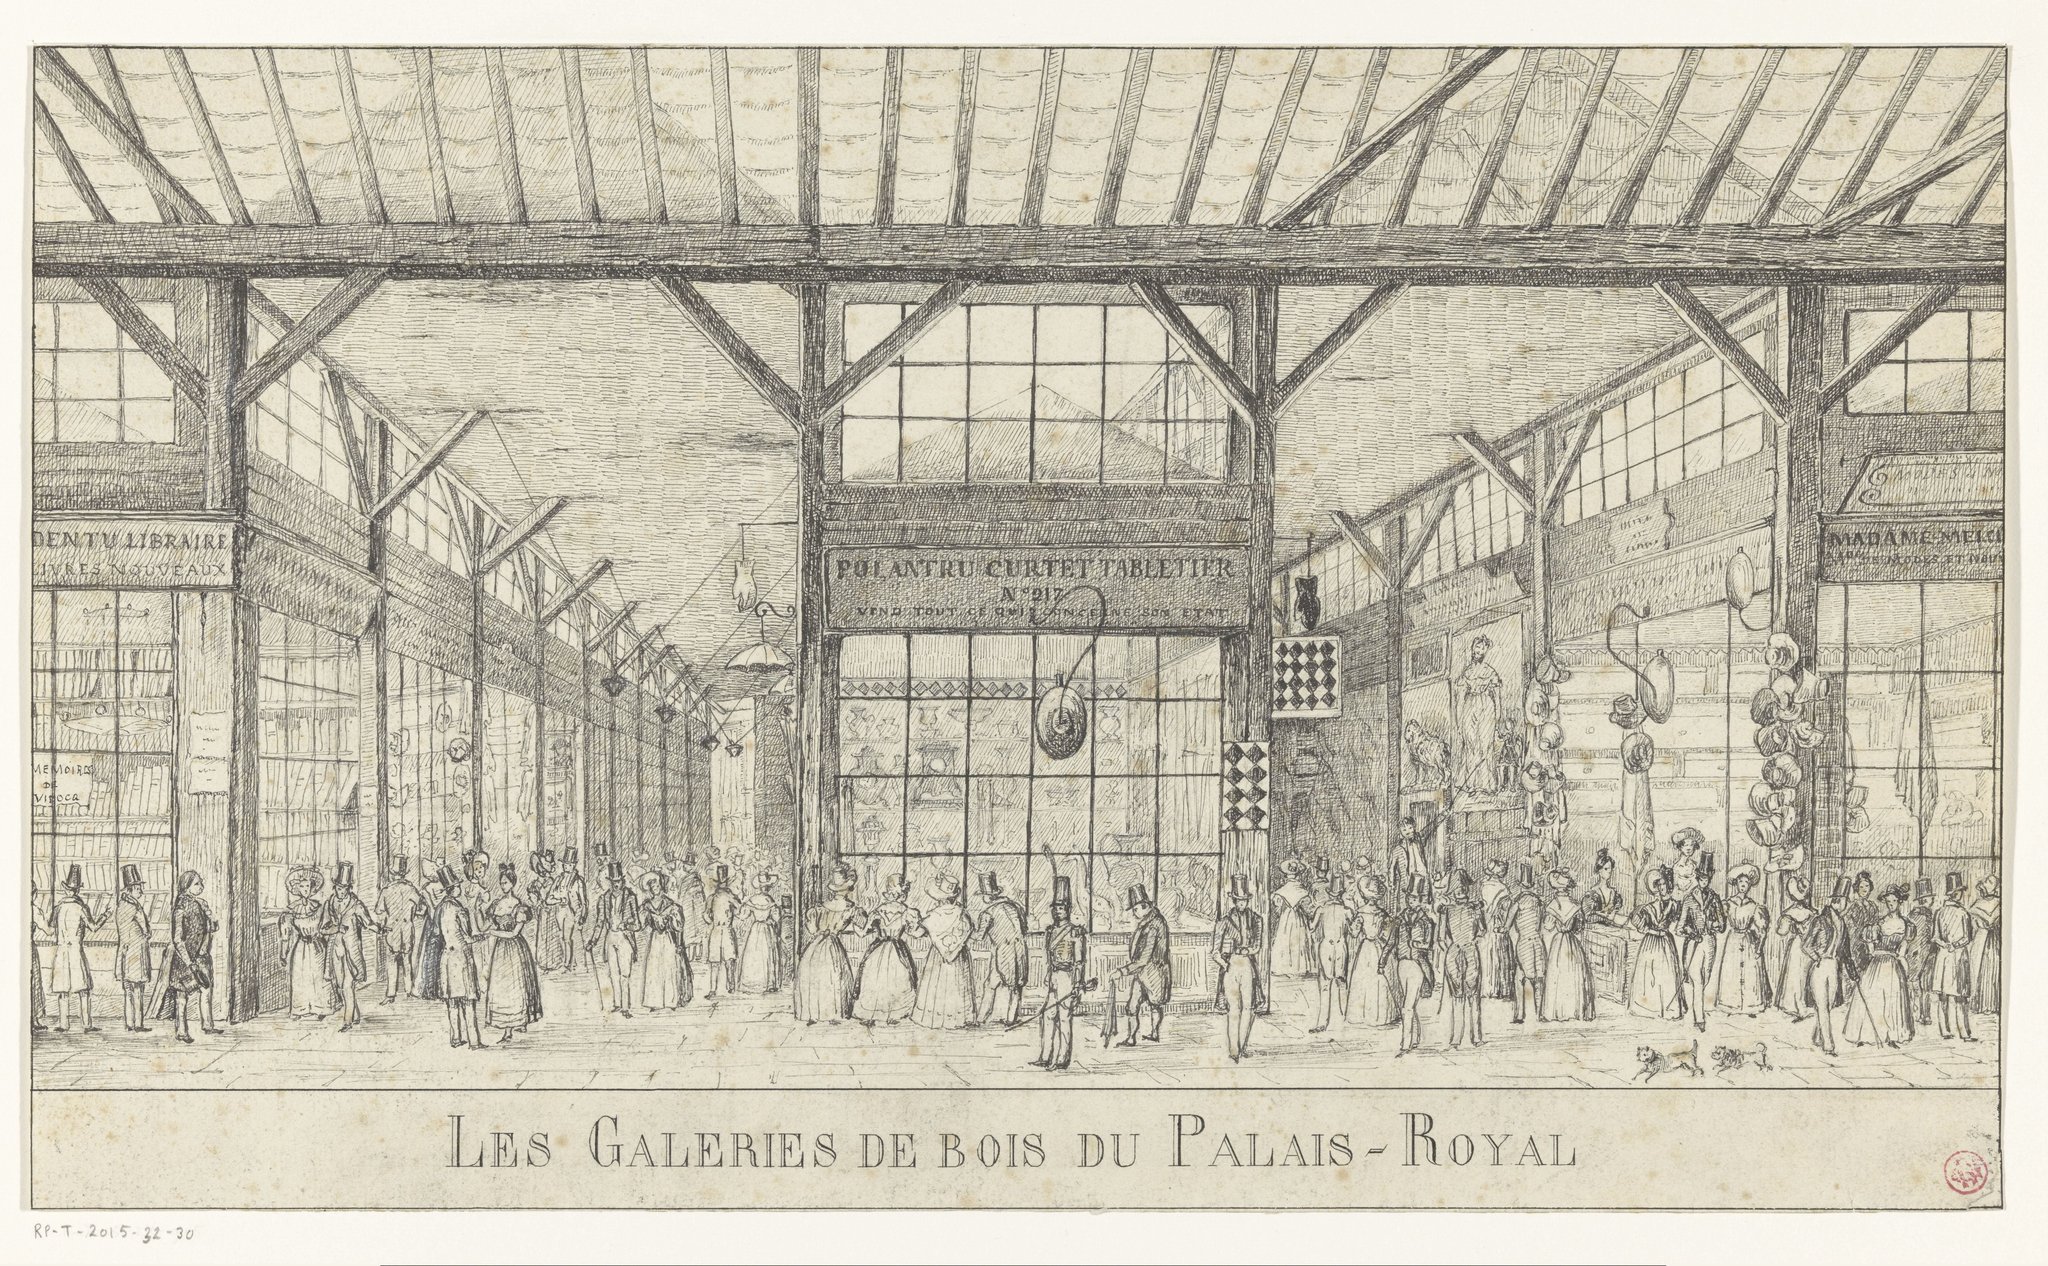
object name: print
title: Les Galeries de Bois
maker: Anonymous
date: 1800-1899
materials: ink, paper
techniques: pen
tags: shop-window, show-window, book-shop, bookseller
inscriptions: collector's mark: Lugt 1157e, collector's mark: Lugt 2228, collector's mark: Lugt 4779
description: Deze houten overdekte galerie werd gebouwd in 1790 en verdween in 1828, waarna ze werd vervangen door de Galerie d'Orléans.